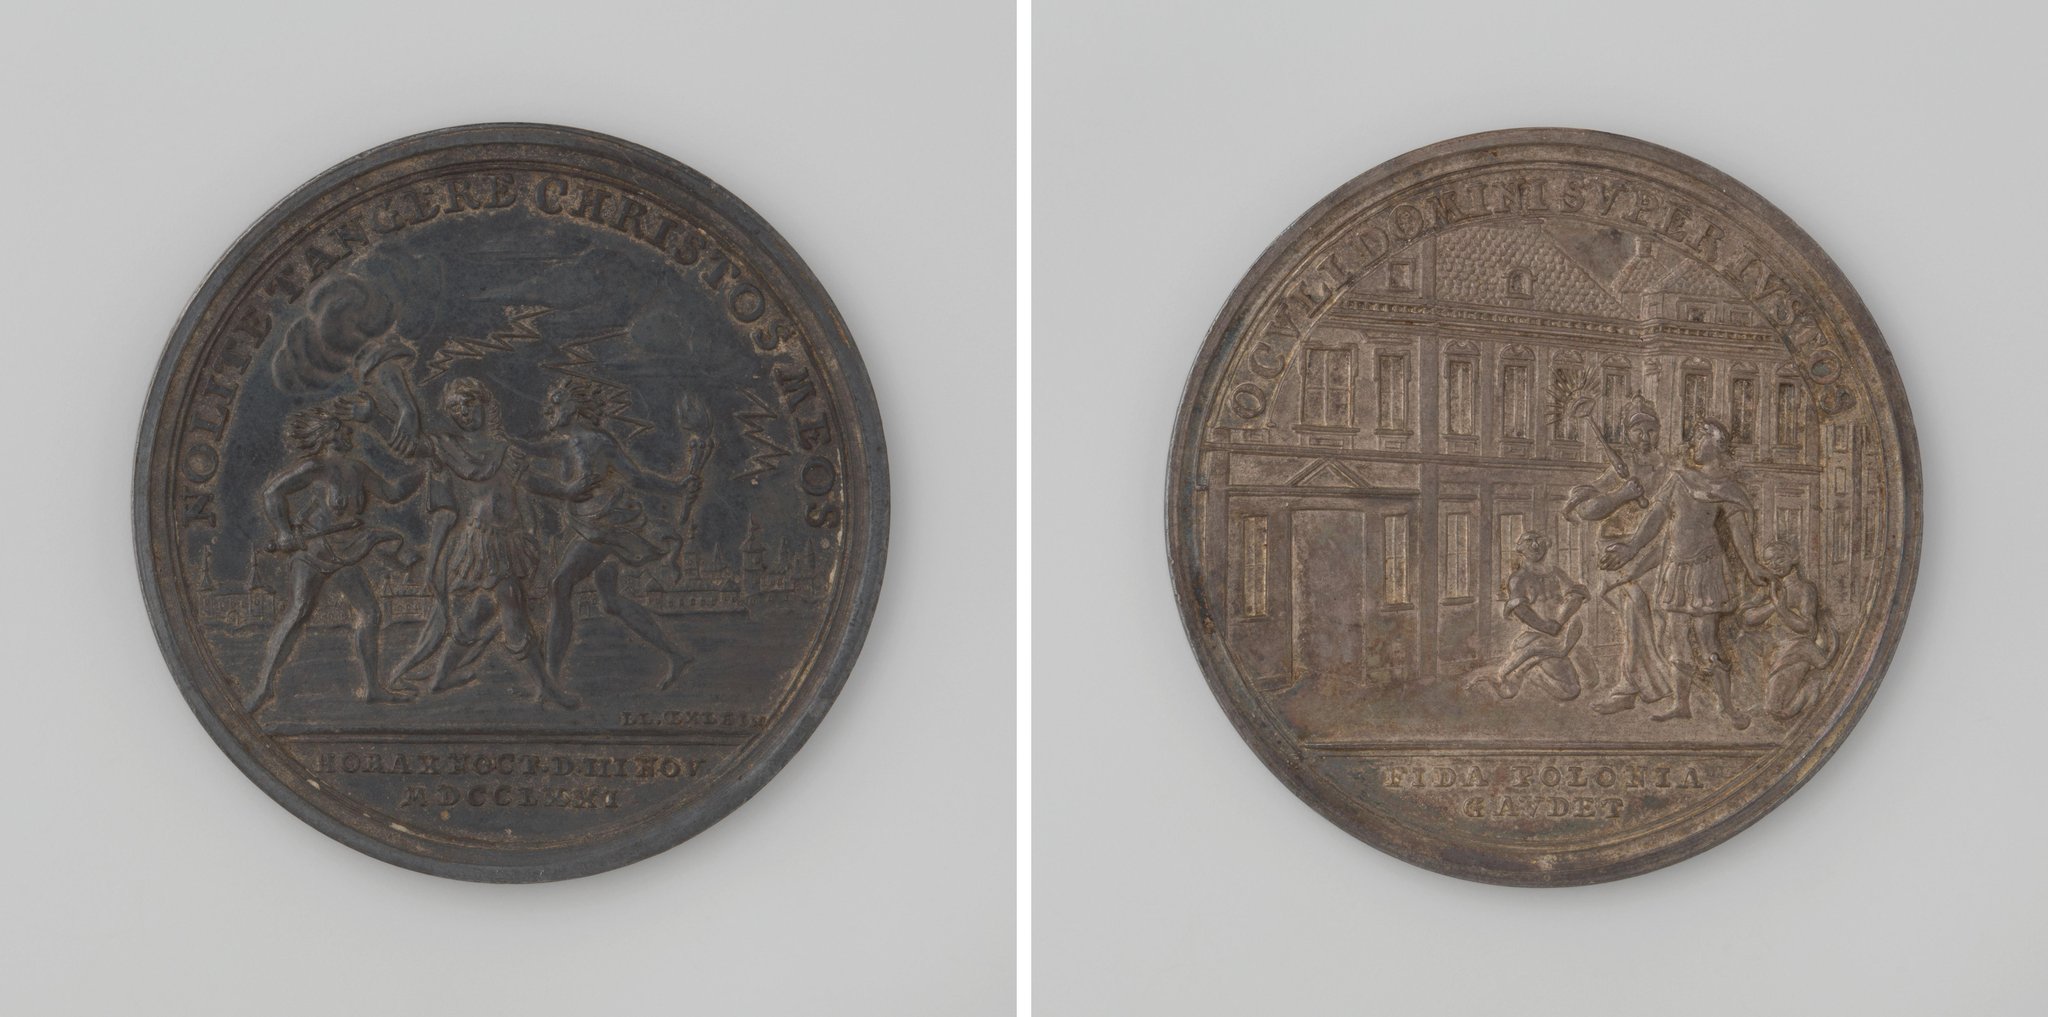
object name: history medal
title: Mislukte aanslag op het leven van Stanislaus II Augustus Poniatowski, koning van Polen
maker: johann leonhard öxlein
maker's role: mintmaster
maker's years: 1715-1787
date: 1771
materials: silver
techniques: striking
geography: nuremberg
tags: wolczyn, sint-petersburg, koning, stanislaus ii augustus poniatovski (koning van polen)